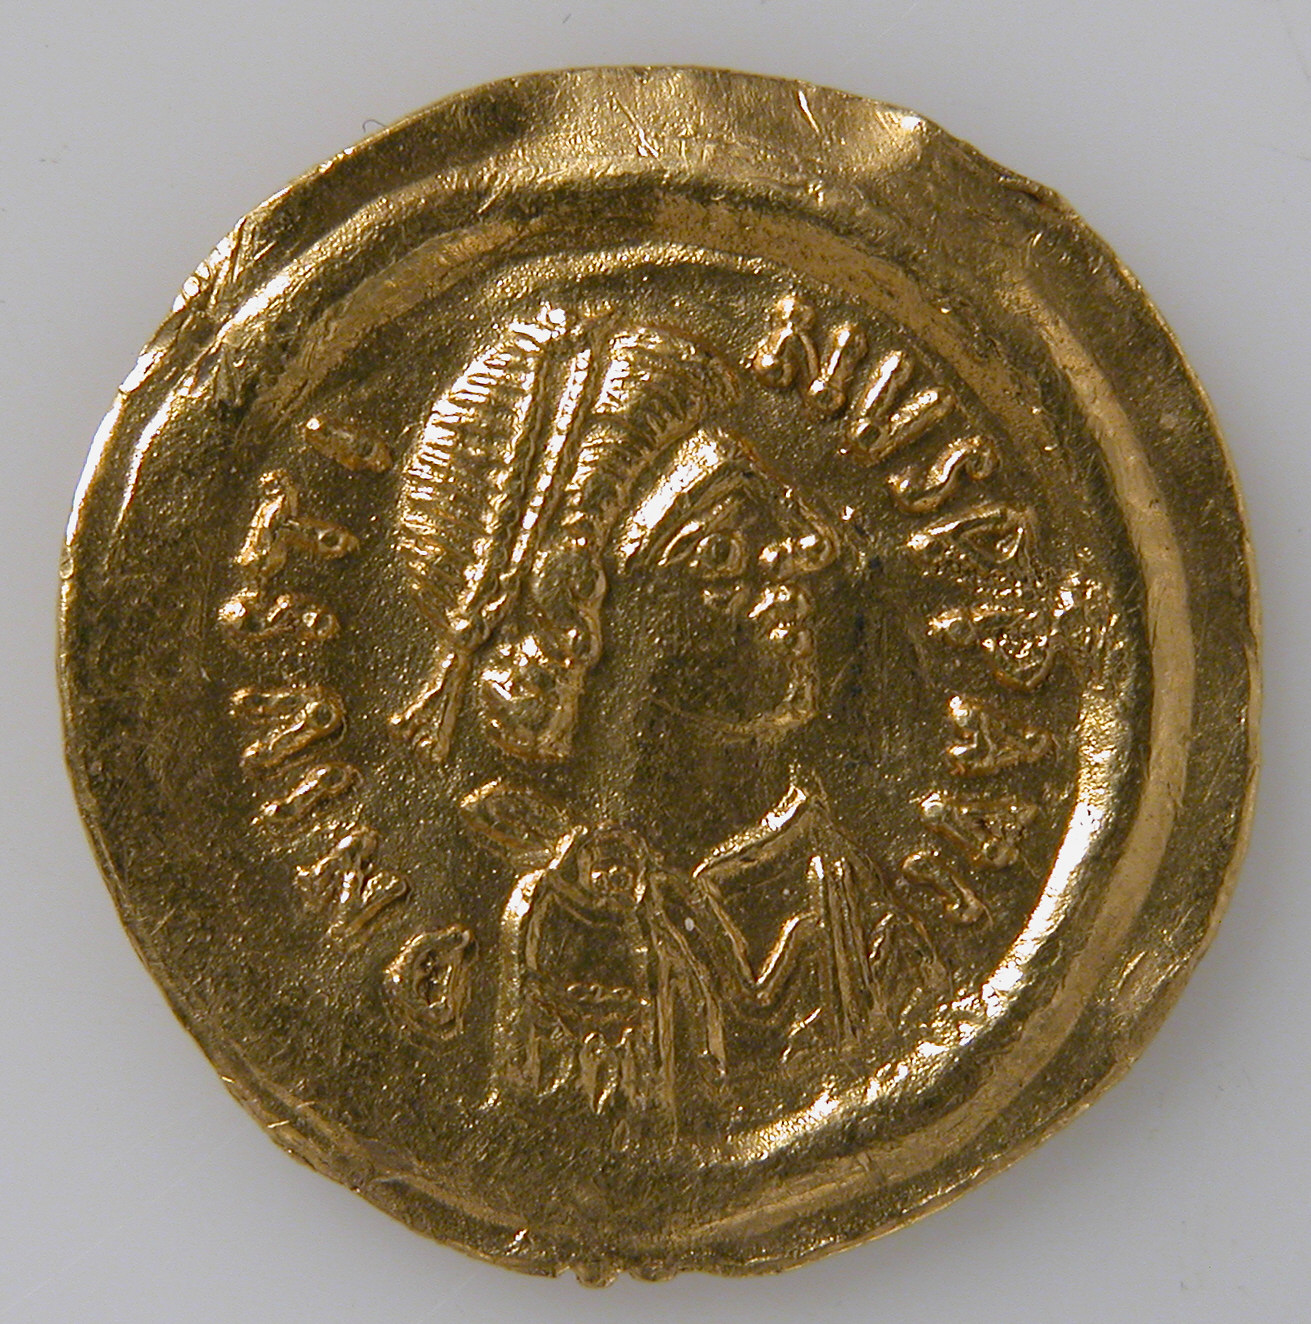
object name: tremissis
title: Tremissis of Mauricius Tiberius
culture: byzantine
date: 582-602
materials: gold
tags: profiles